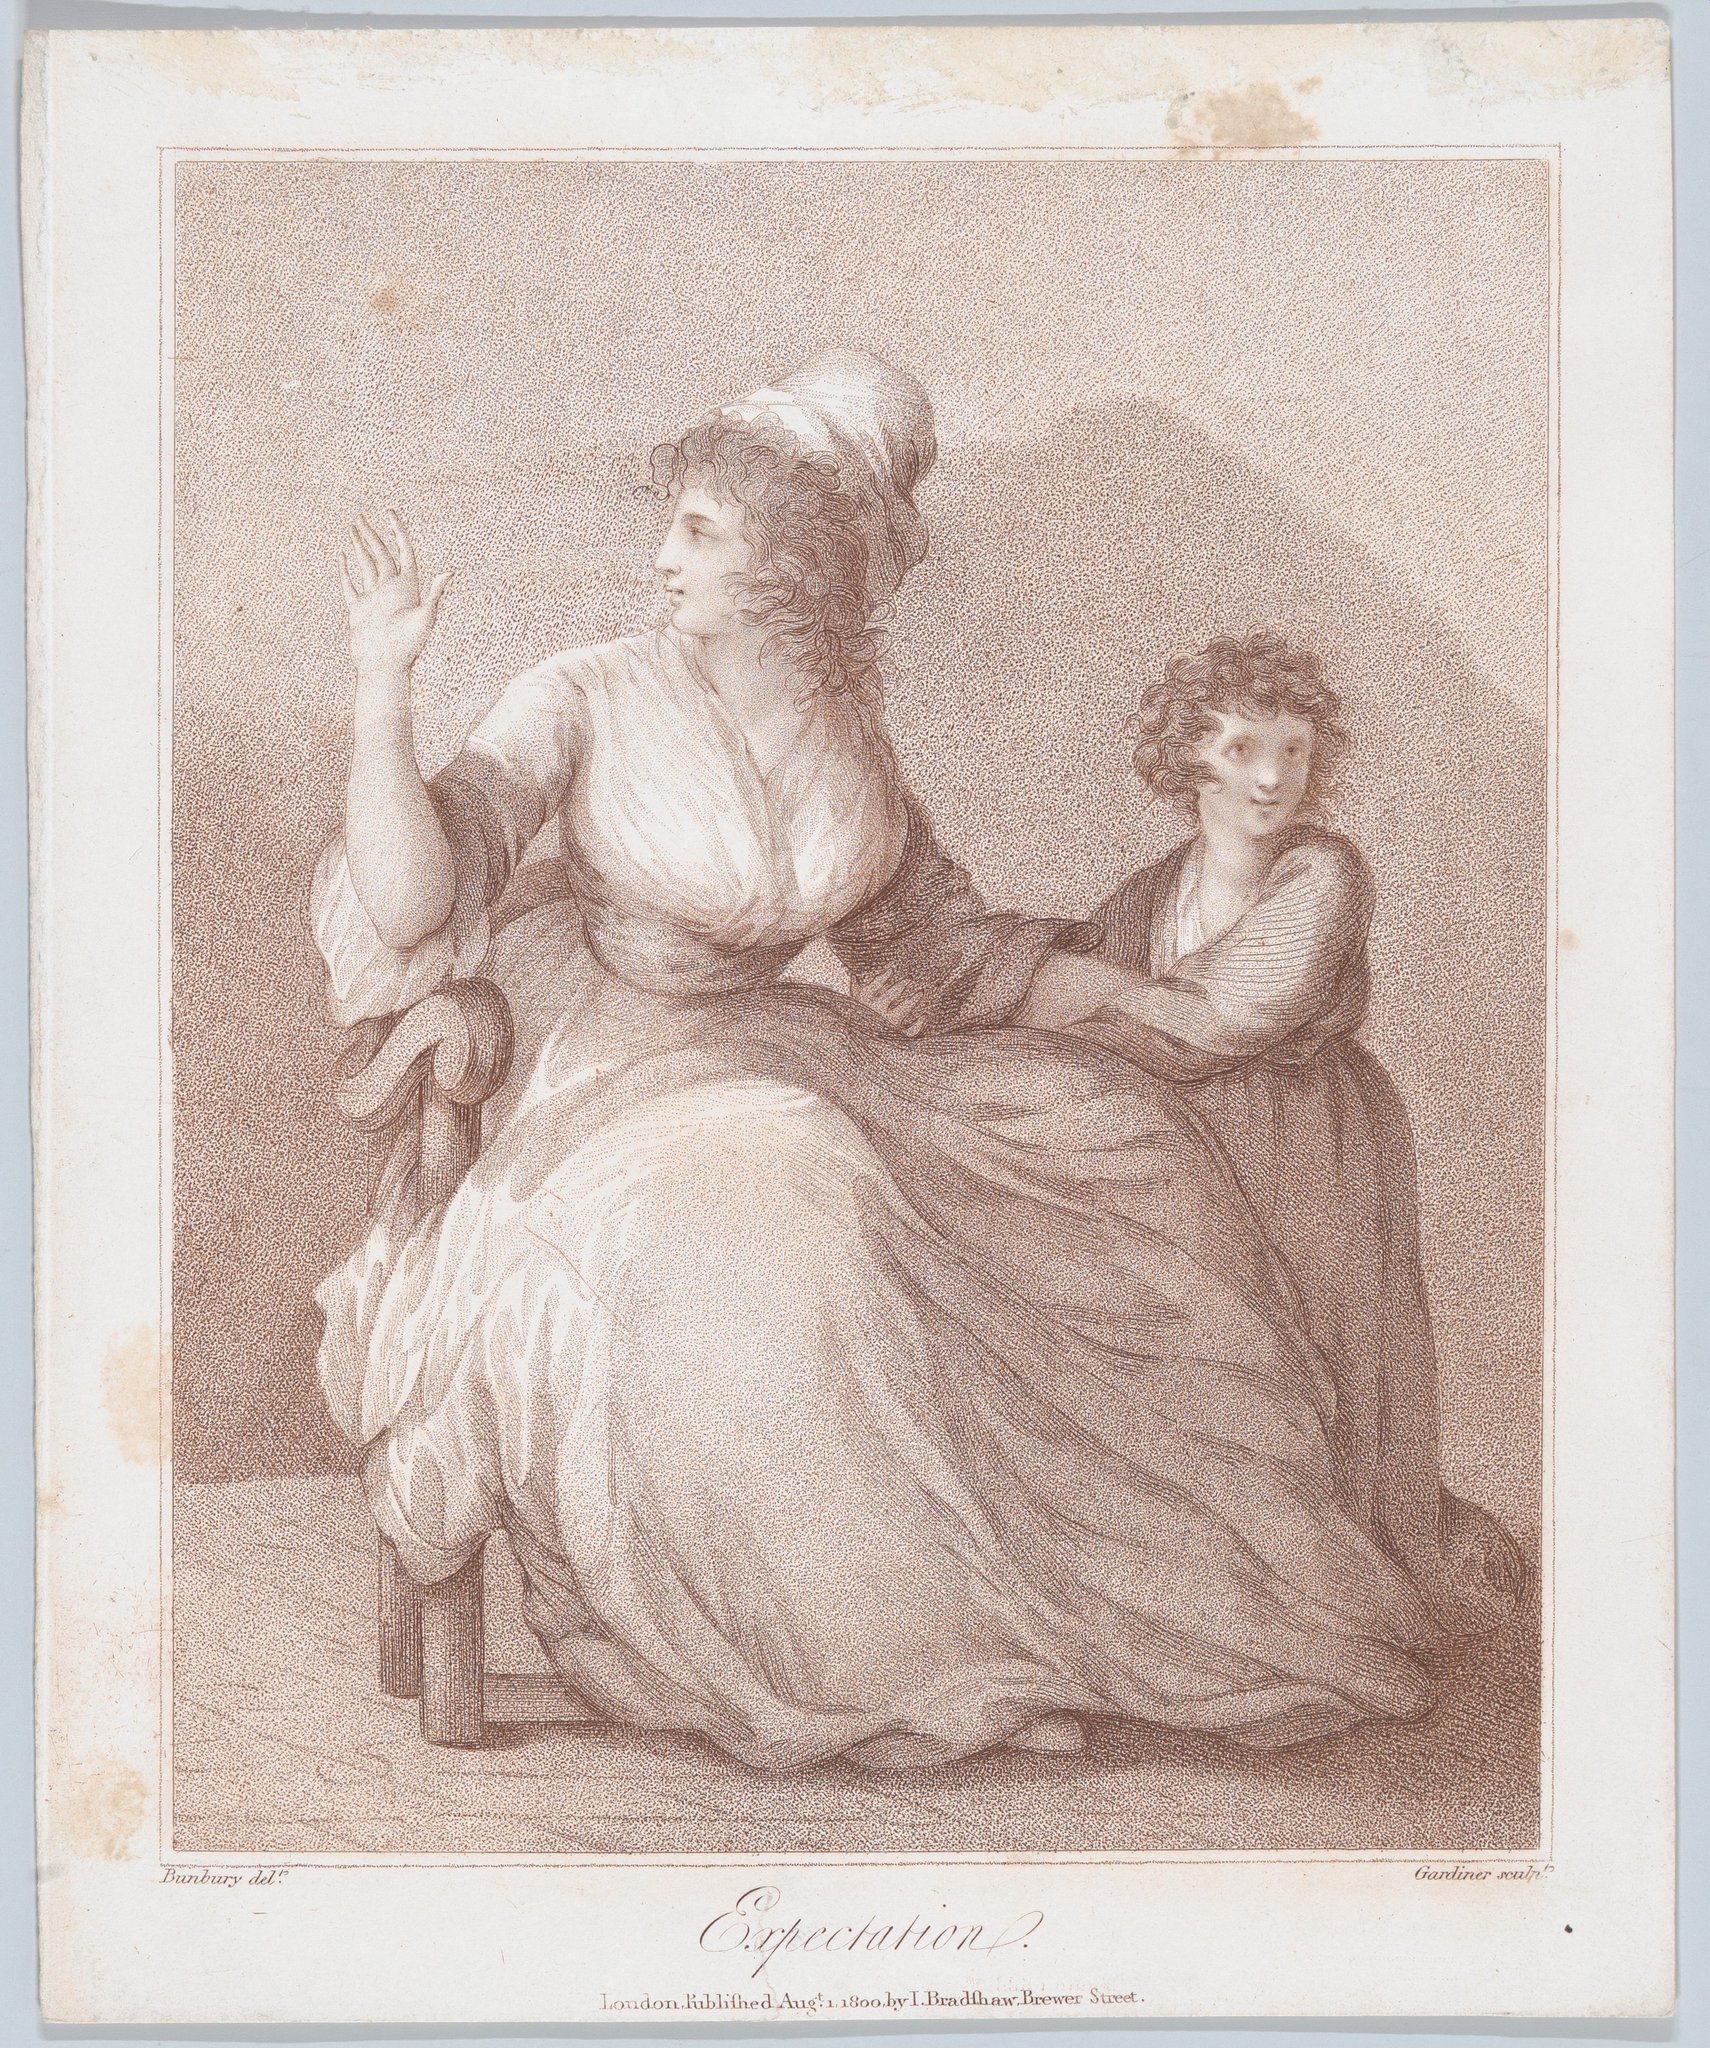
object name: print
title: Expectation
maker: william nelson gardiner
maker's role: engraver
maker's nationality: british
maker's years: 1766-1814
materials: ink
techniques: printing, engraving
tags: children,women